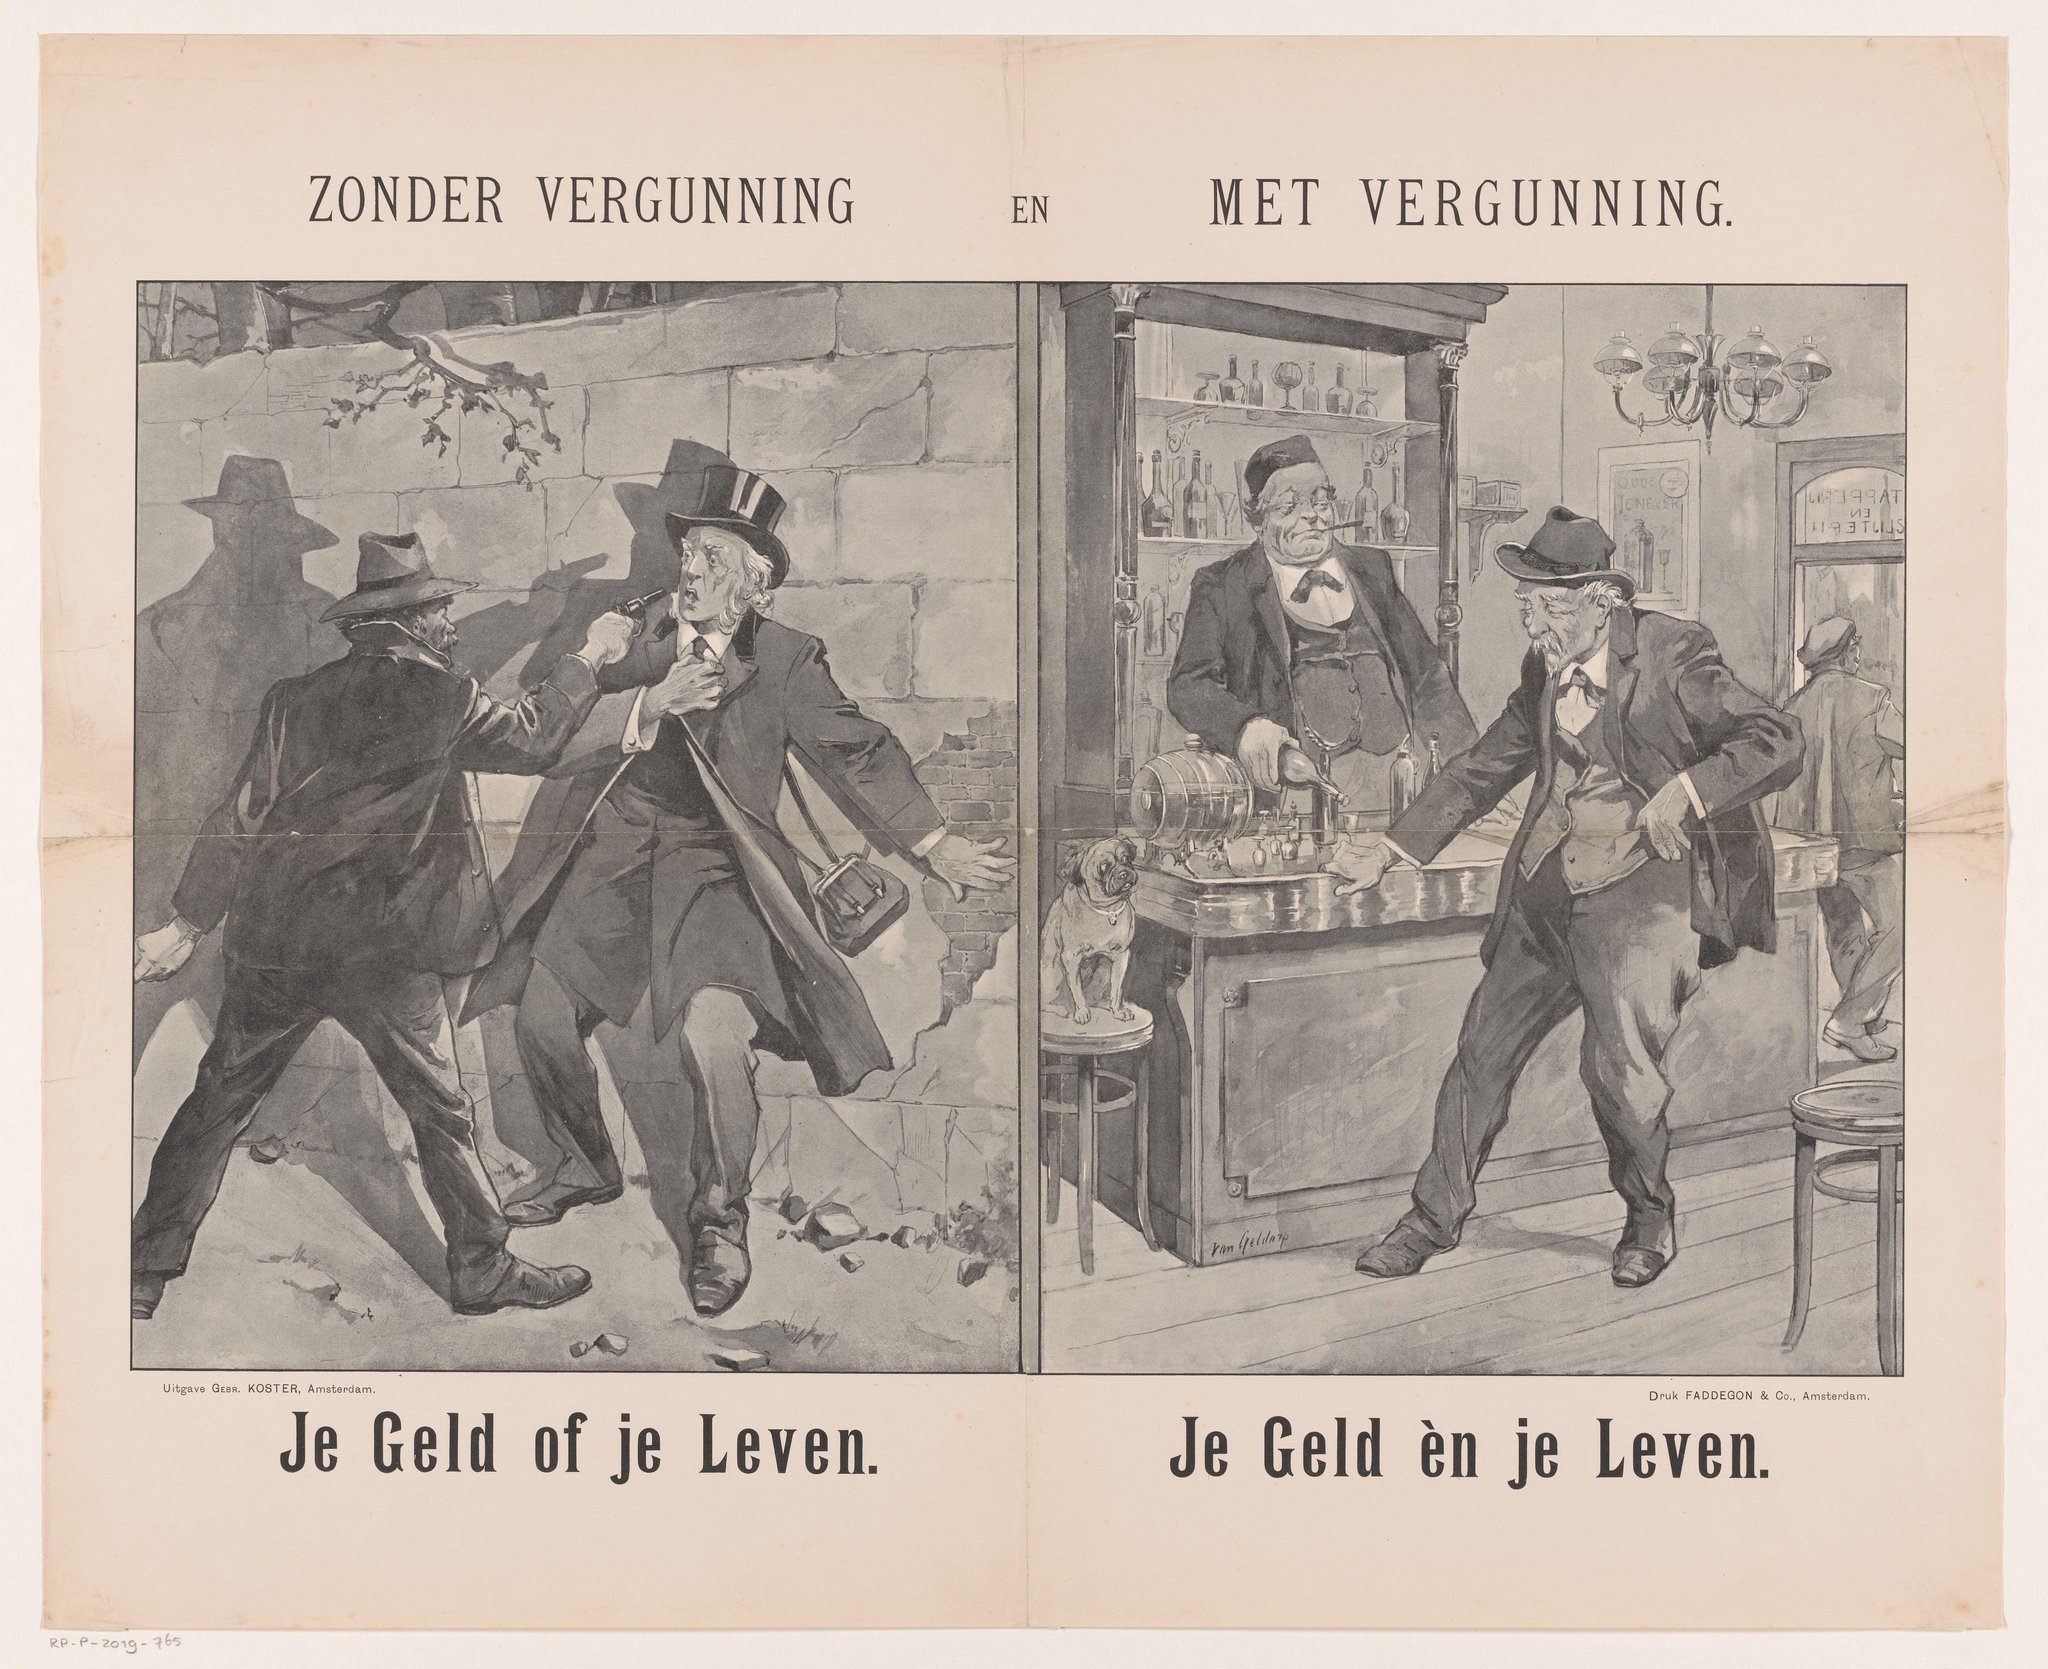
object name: poster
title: Man wordt bedreigd met vuurwapen en man aan een bar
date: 1900-1914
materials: paper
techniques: photochemical processes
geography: amsterdam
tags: inn, coffee-house, public house, etc., firearms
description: Links een man die wordt bedreigd met een vuurwapen voor een stenen muur. Rechts dezelfde man aan een bar waar voor hem een drankje wordt ingeschonken.